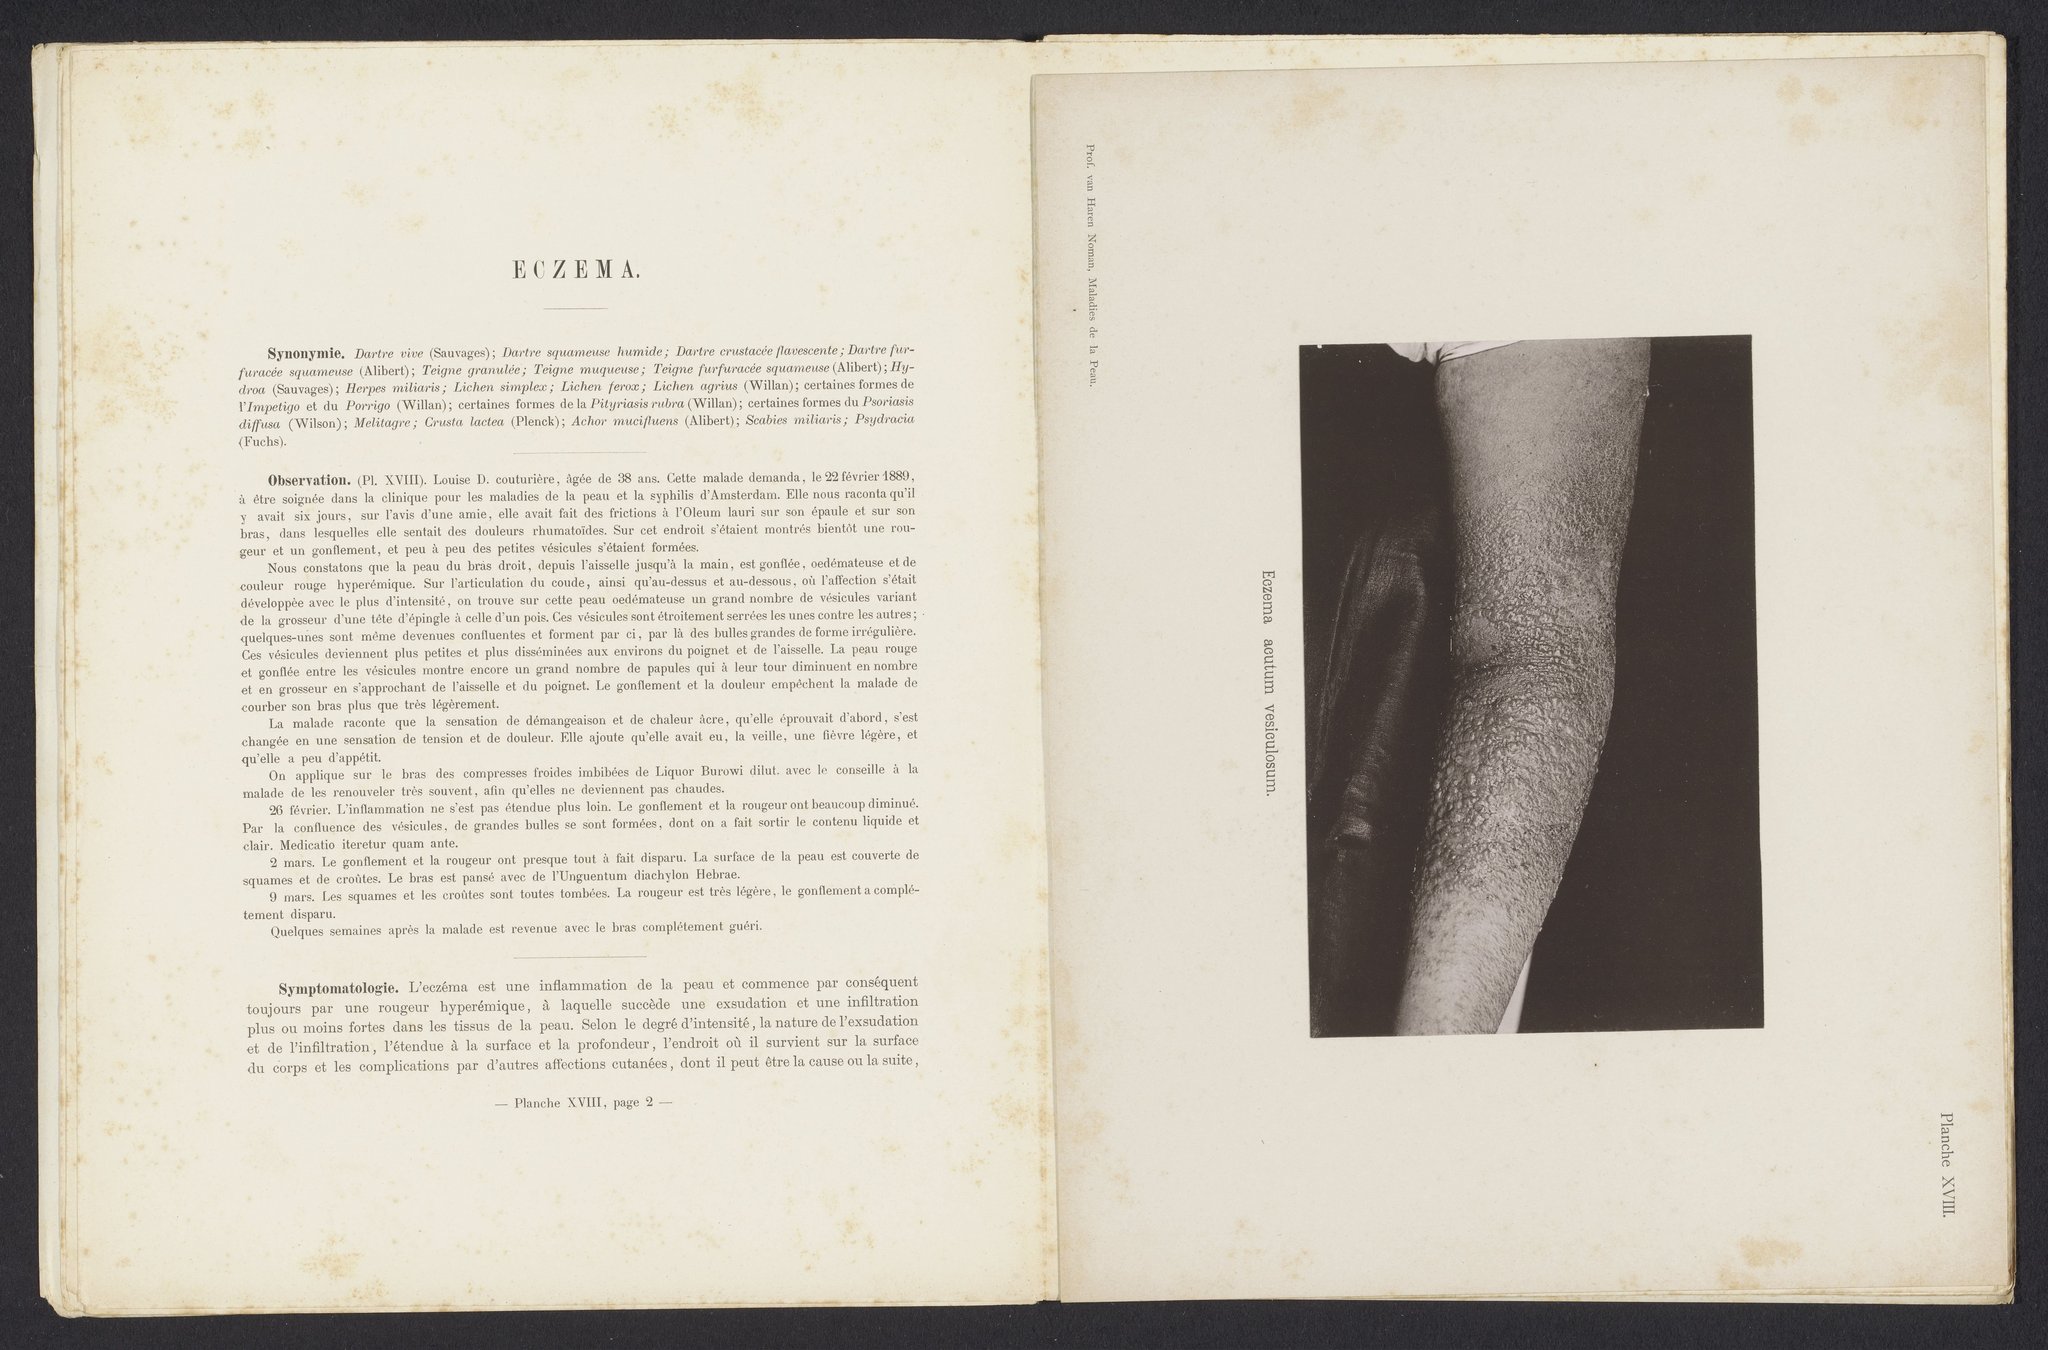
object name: photomechanical print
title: Eczema acutum vesiculosum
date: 1880-1890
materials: paper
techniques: photograph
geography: haarlem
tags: skin and venereal diseases, arms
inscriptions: number: ‘Planche XVIII.’